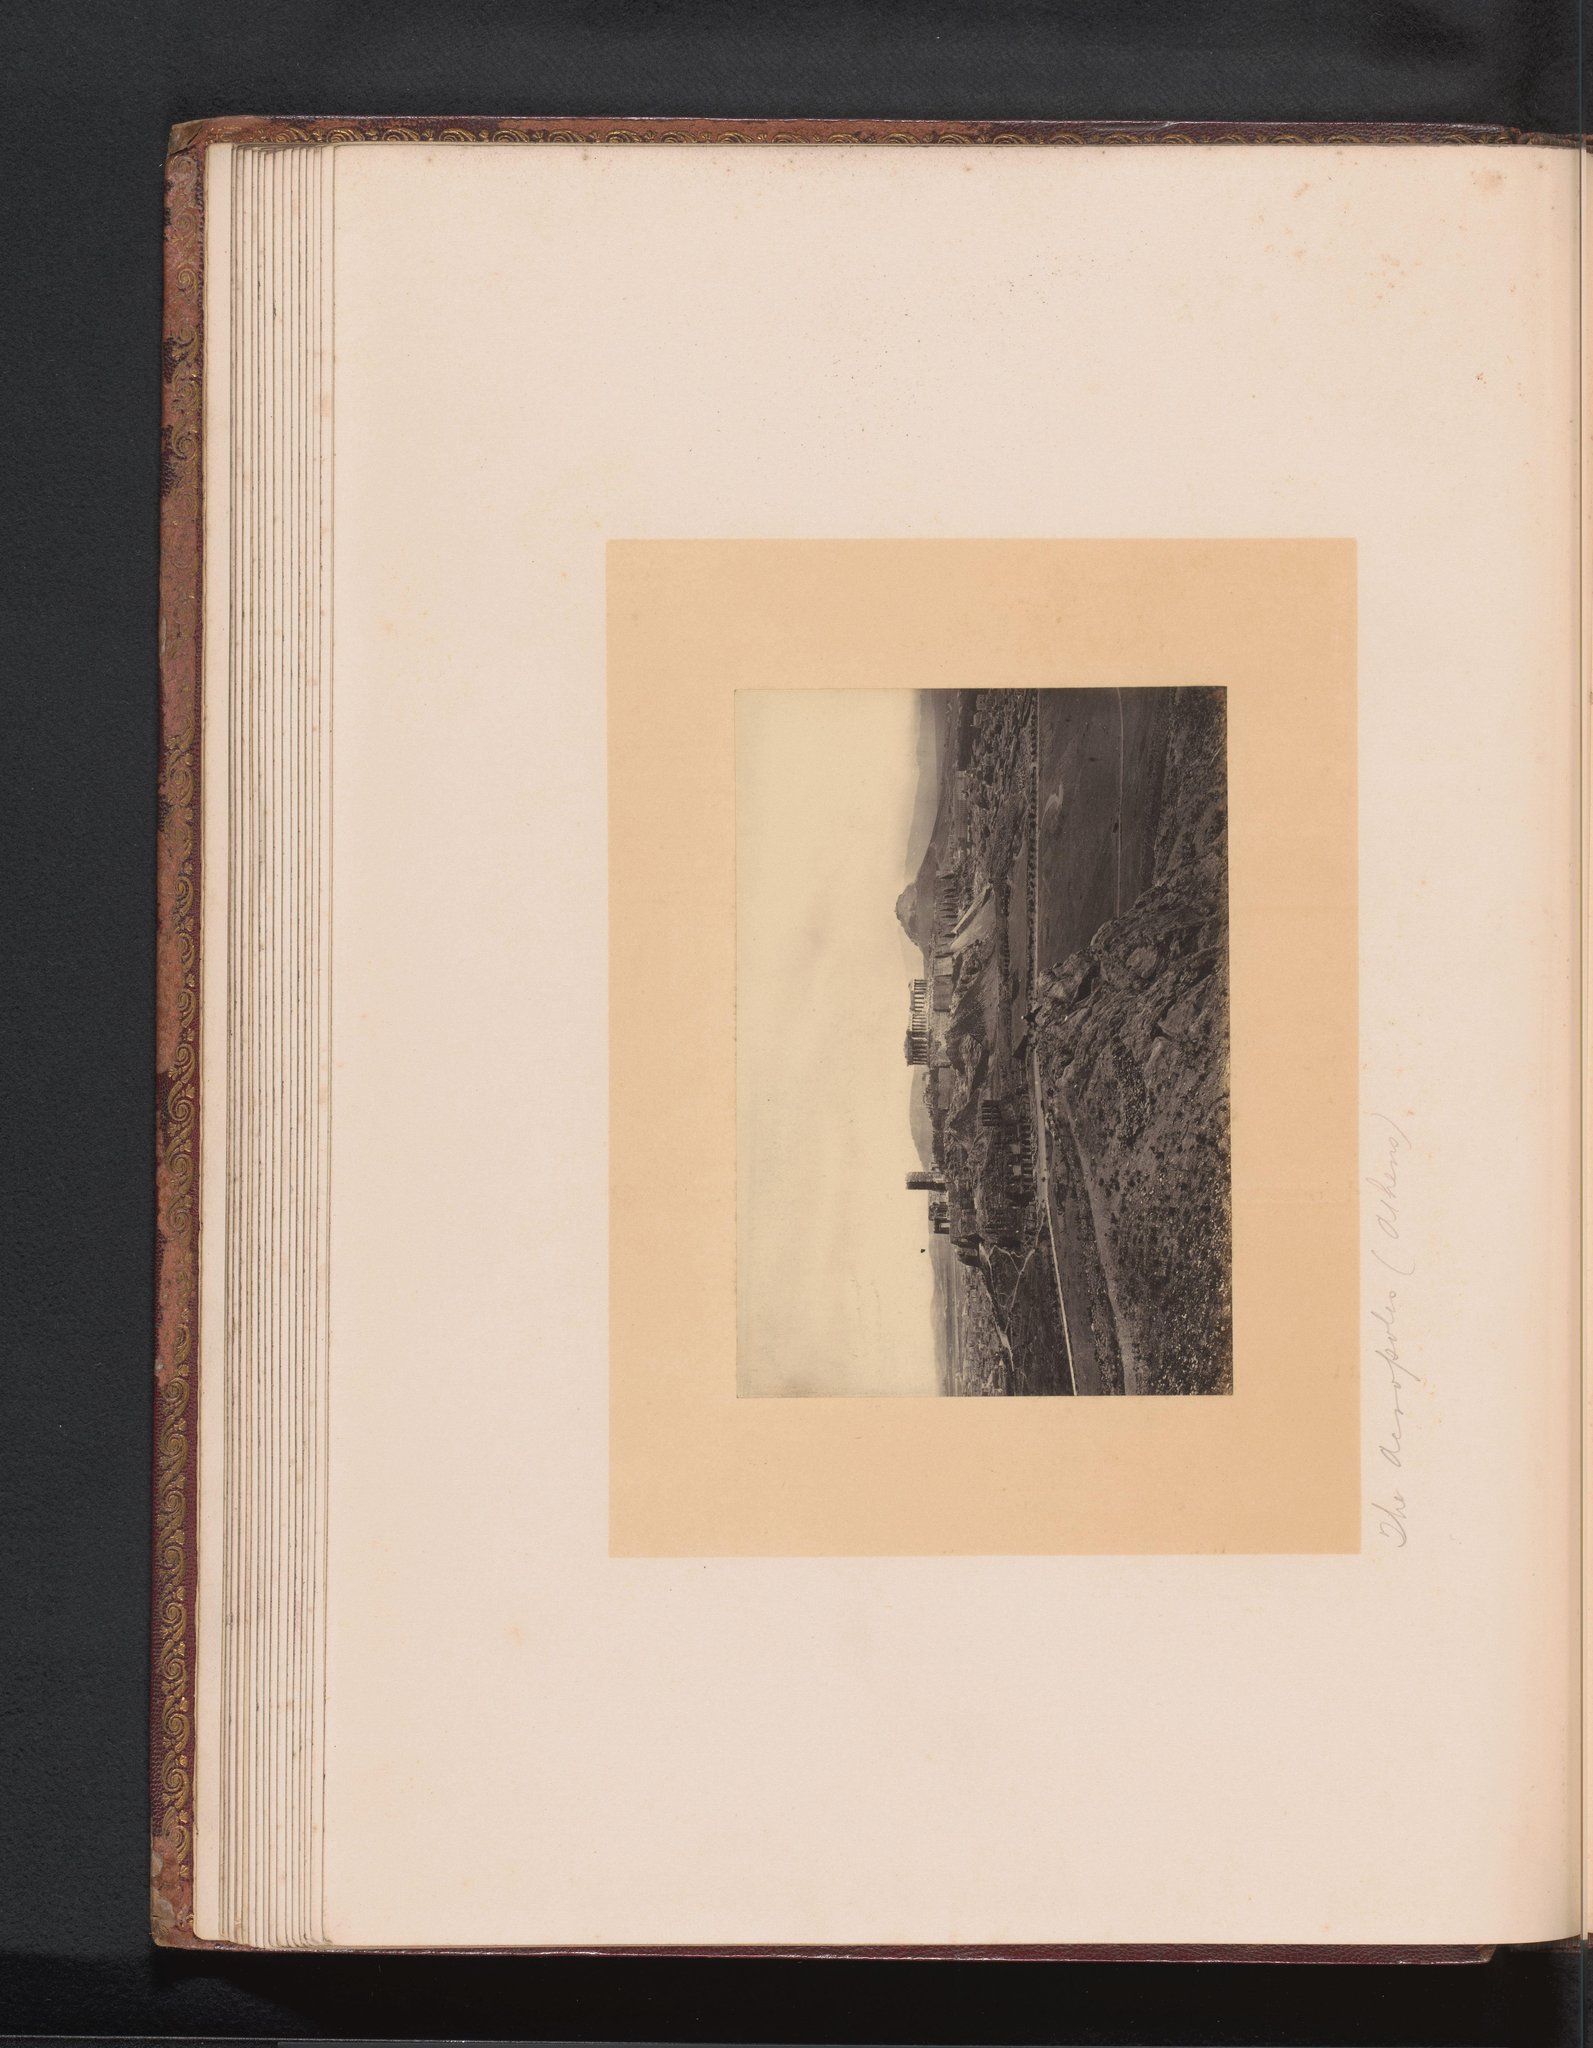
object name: photograph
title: Gezicht op de Akropolis van Athene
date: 1870-1875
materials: photographic support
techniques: albumen print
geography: athens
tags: city-view in general; 'veduta', temple, shrine ~ greek religion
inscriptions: annotation: ‘The Acropolis (Athens)’